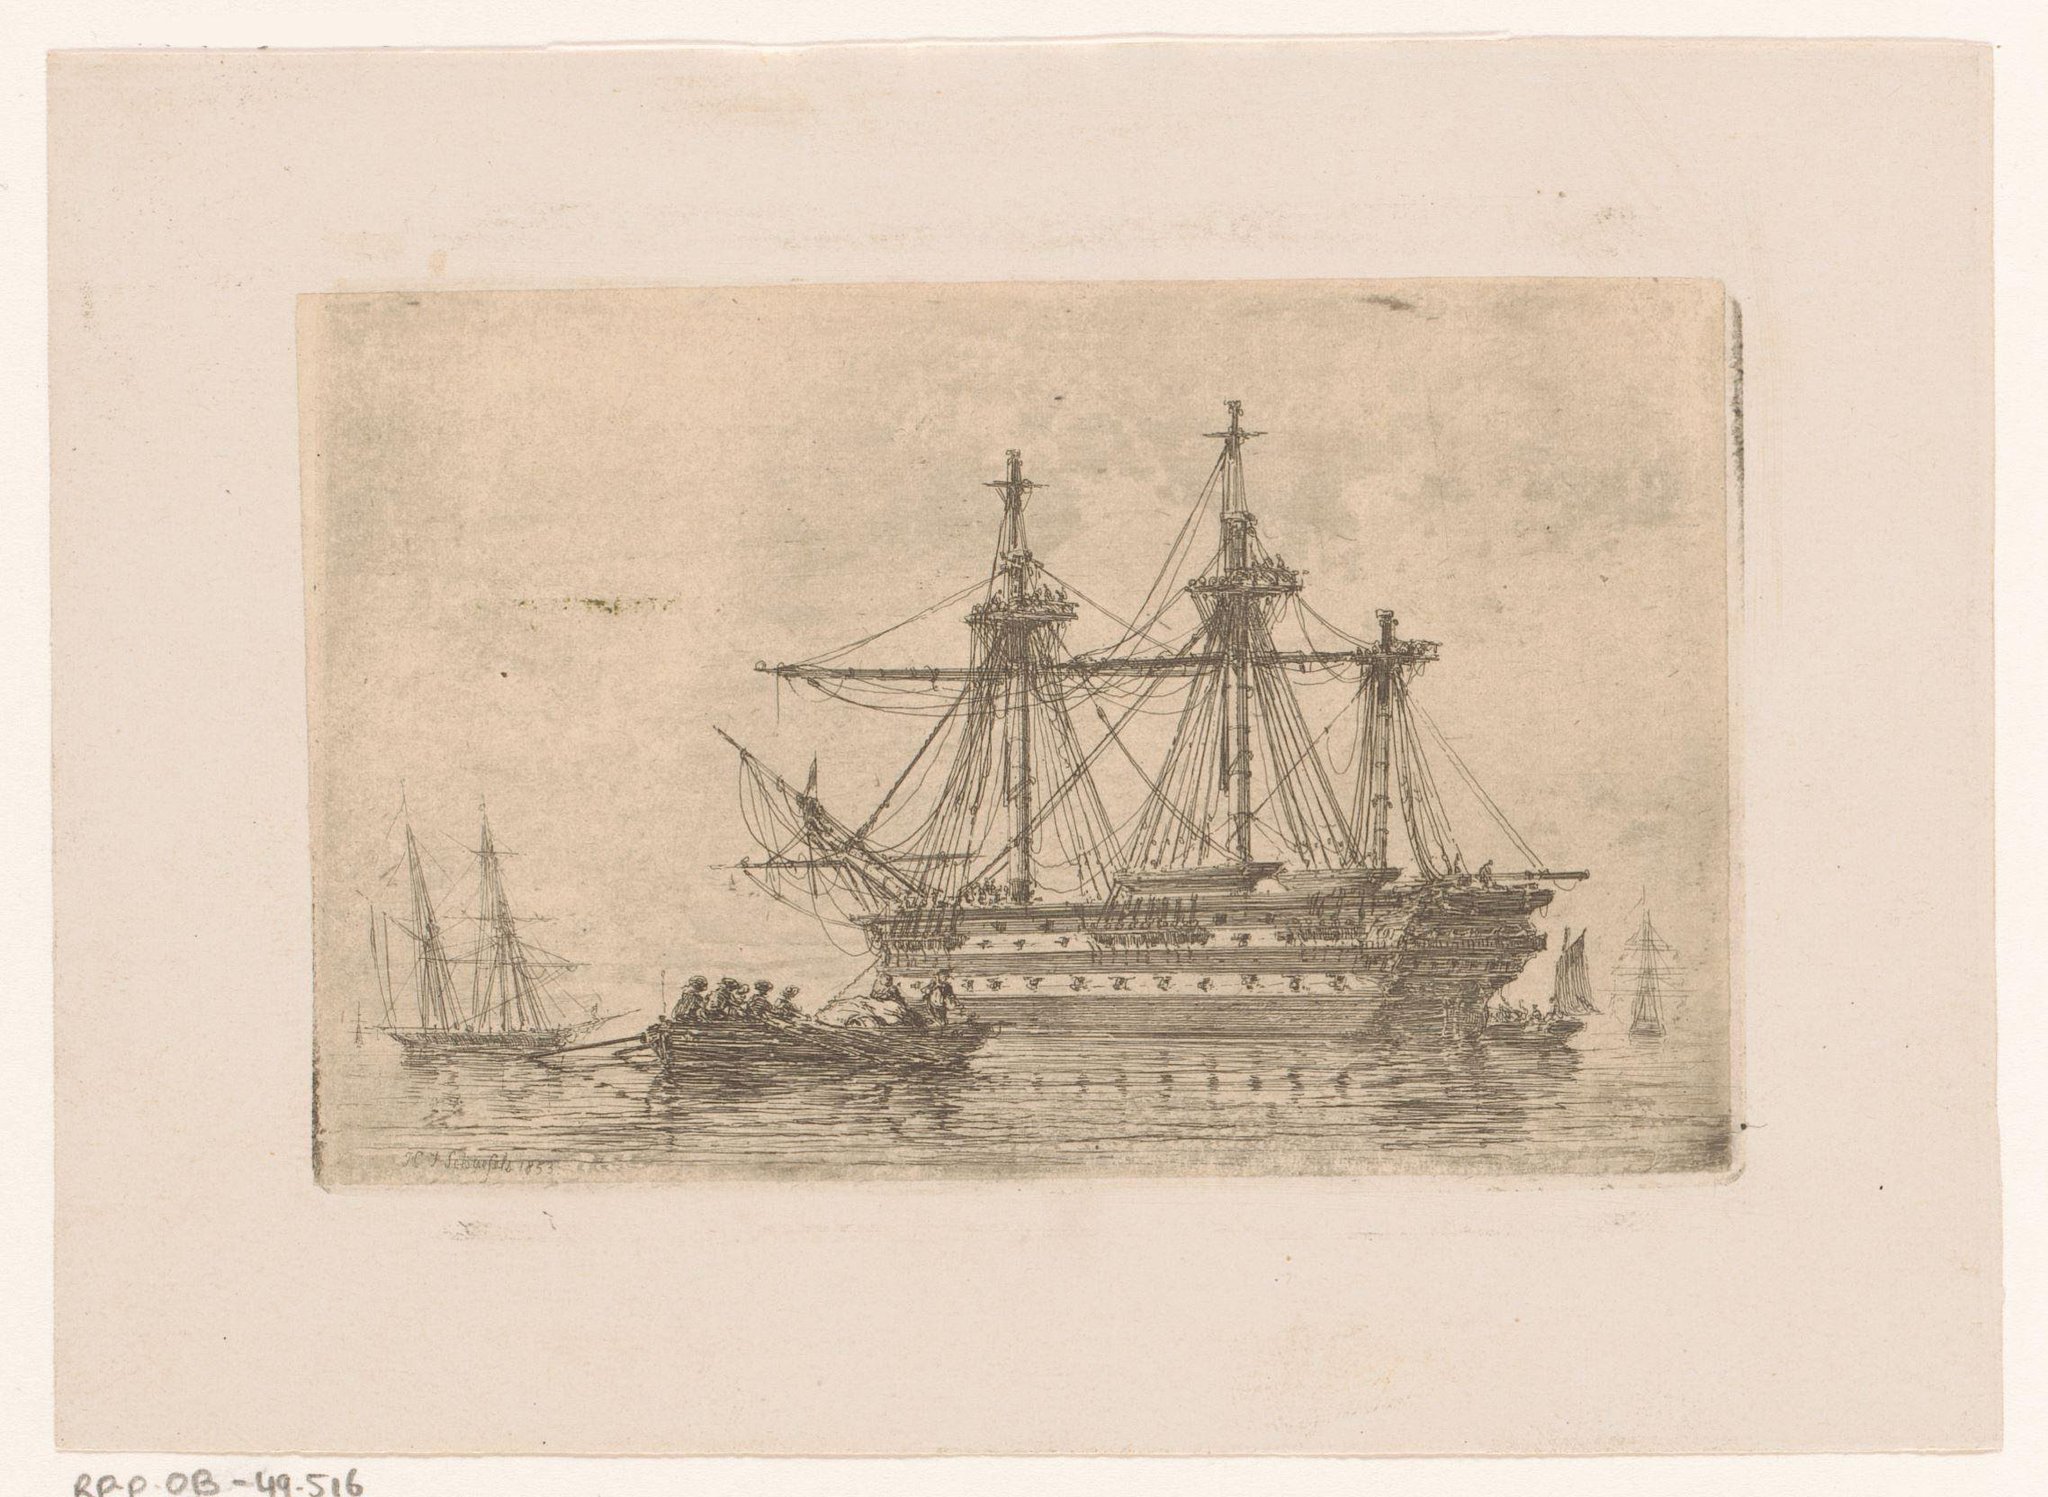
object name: print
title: Oorlogsschip met drie masten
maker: henri françois schaefels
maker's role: print maker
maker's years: 1827-1904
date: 1853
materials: paper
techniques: aquatint, etching, intaglio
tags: sailing-ship, sailing-boat, rowing-boat, canoe, etc.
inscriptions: collector's mark: Lugt 2228